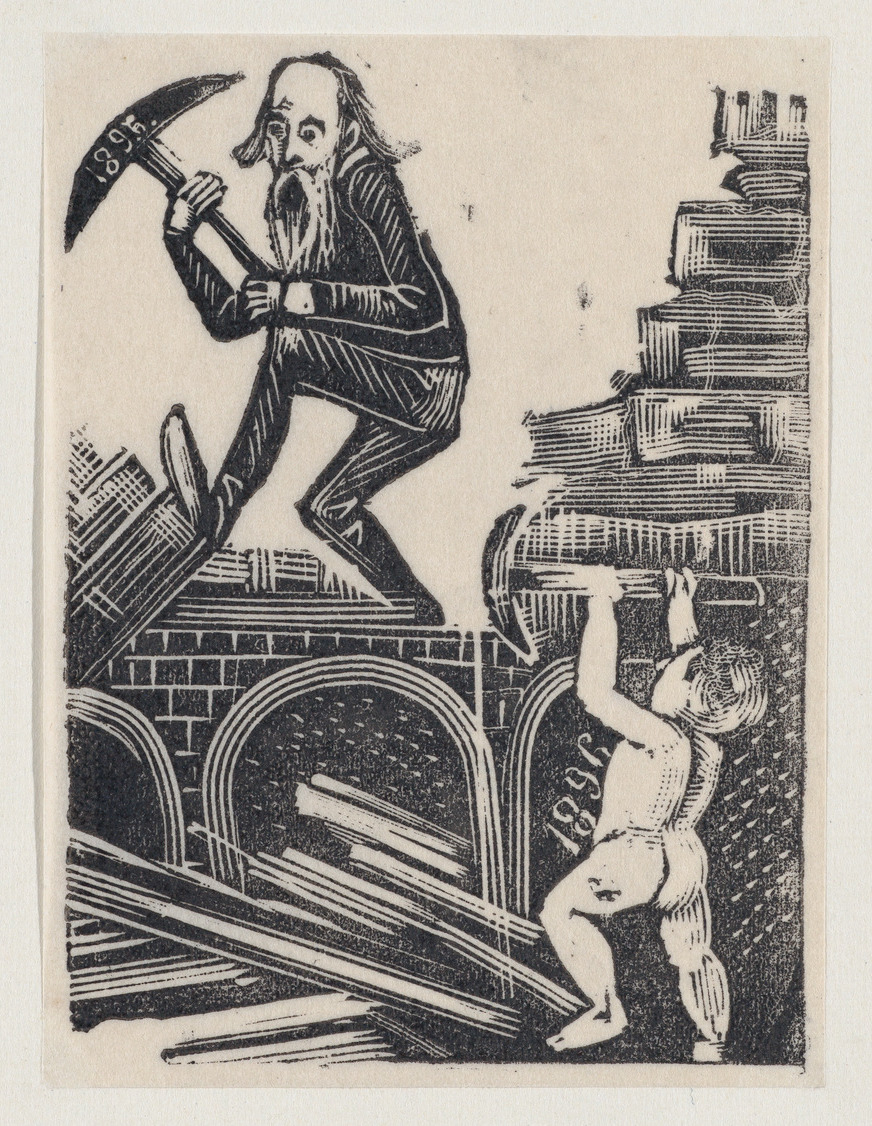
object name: print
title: The New Year 1896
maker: josé guadalupe posada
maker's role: artist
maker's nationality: mexican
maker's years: 1852-1913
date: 1896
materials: metal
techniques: engraving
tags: infants,men